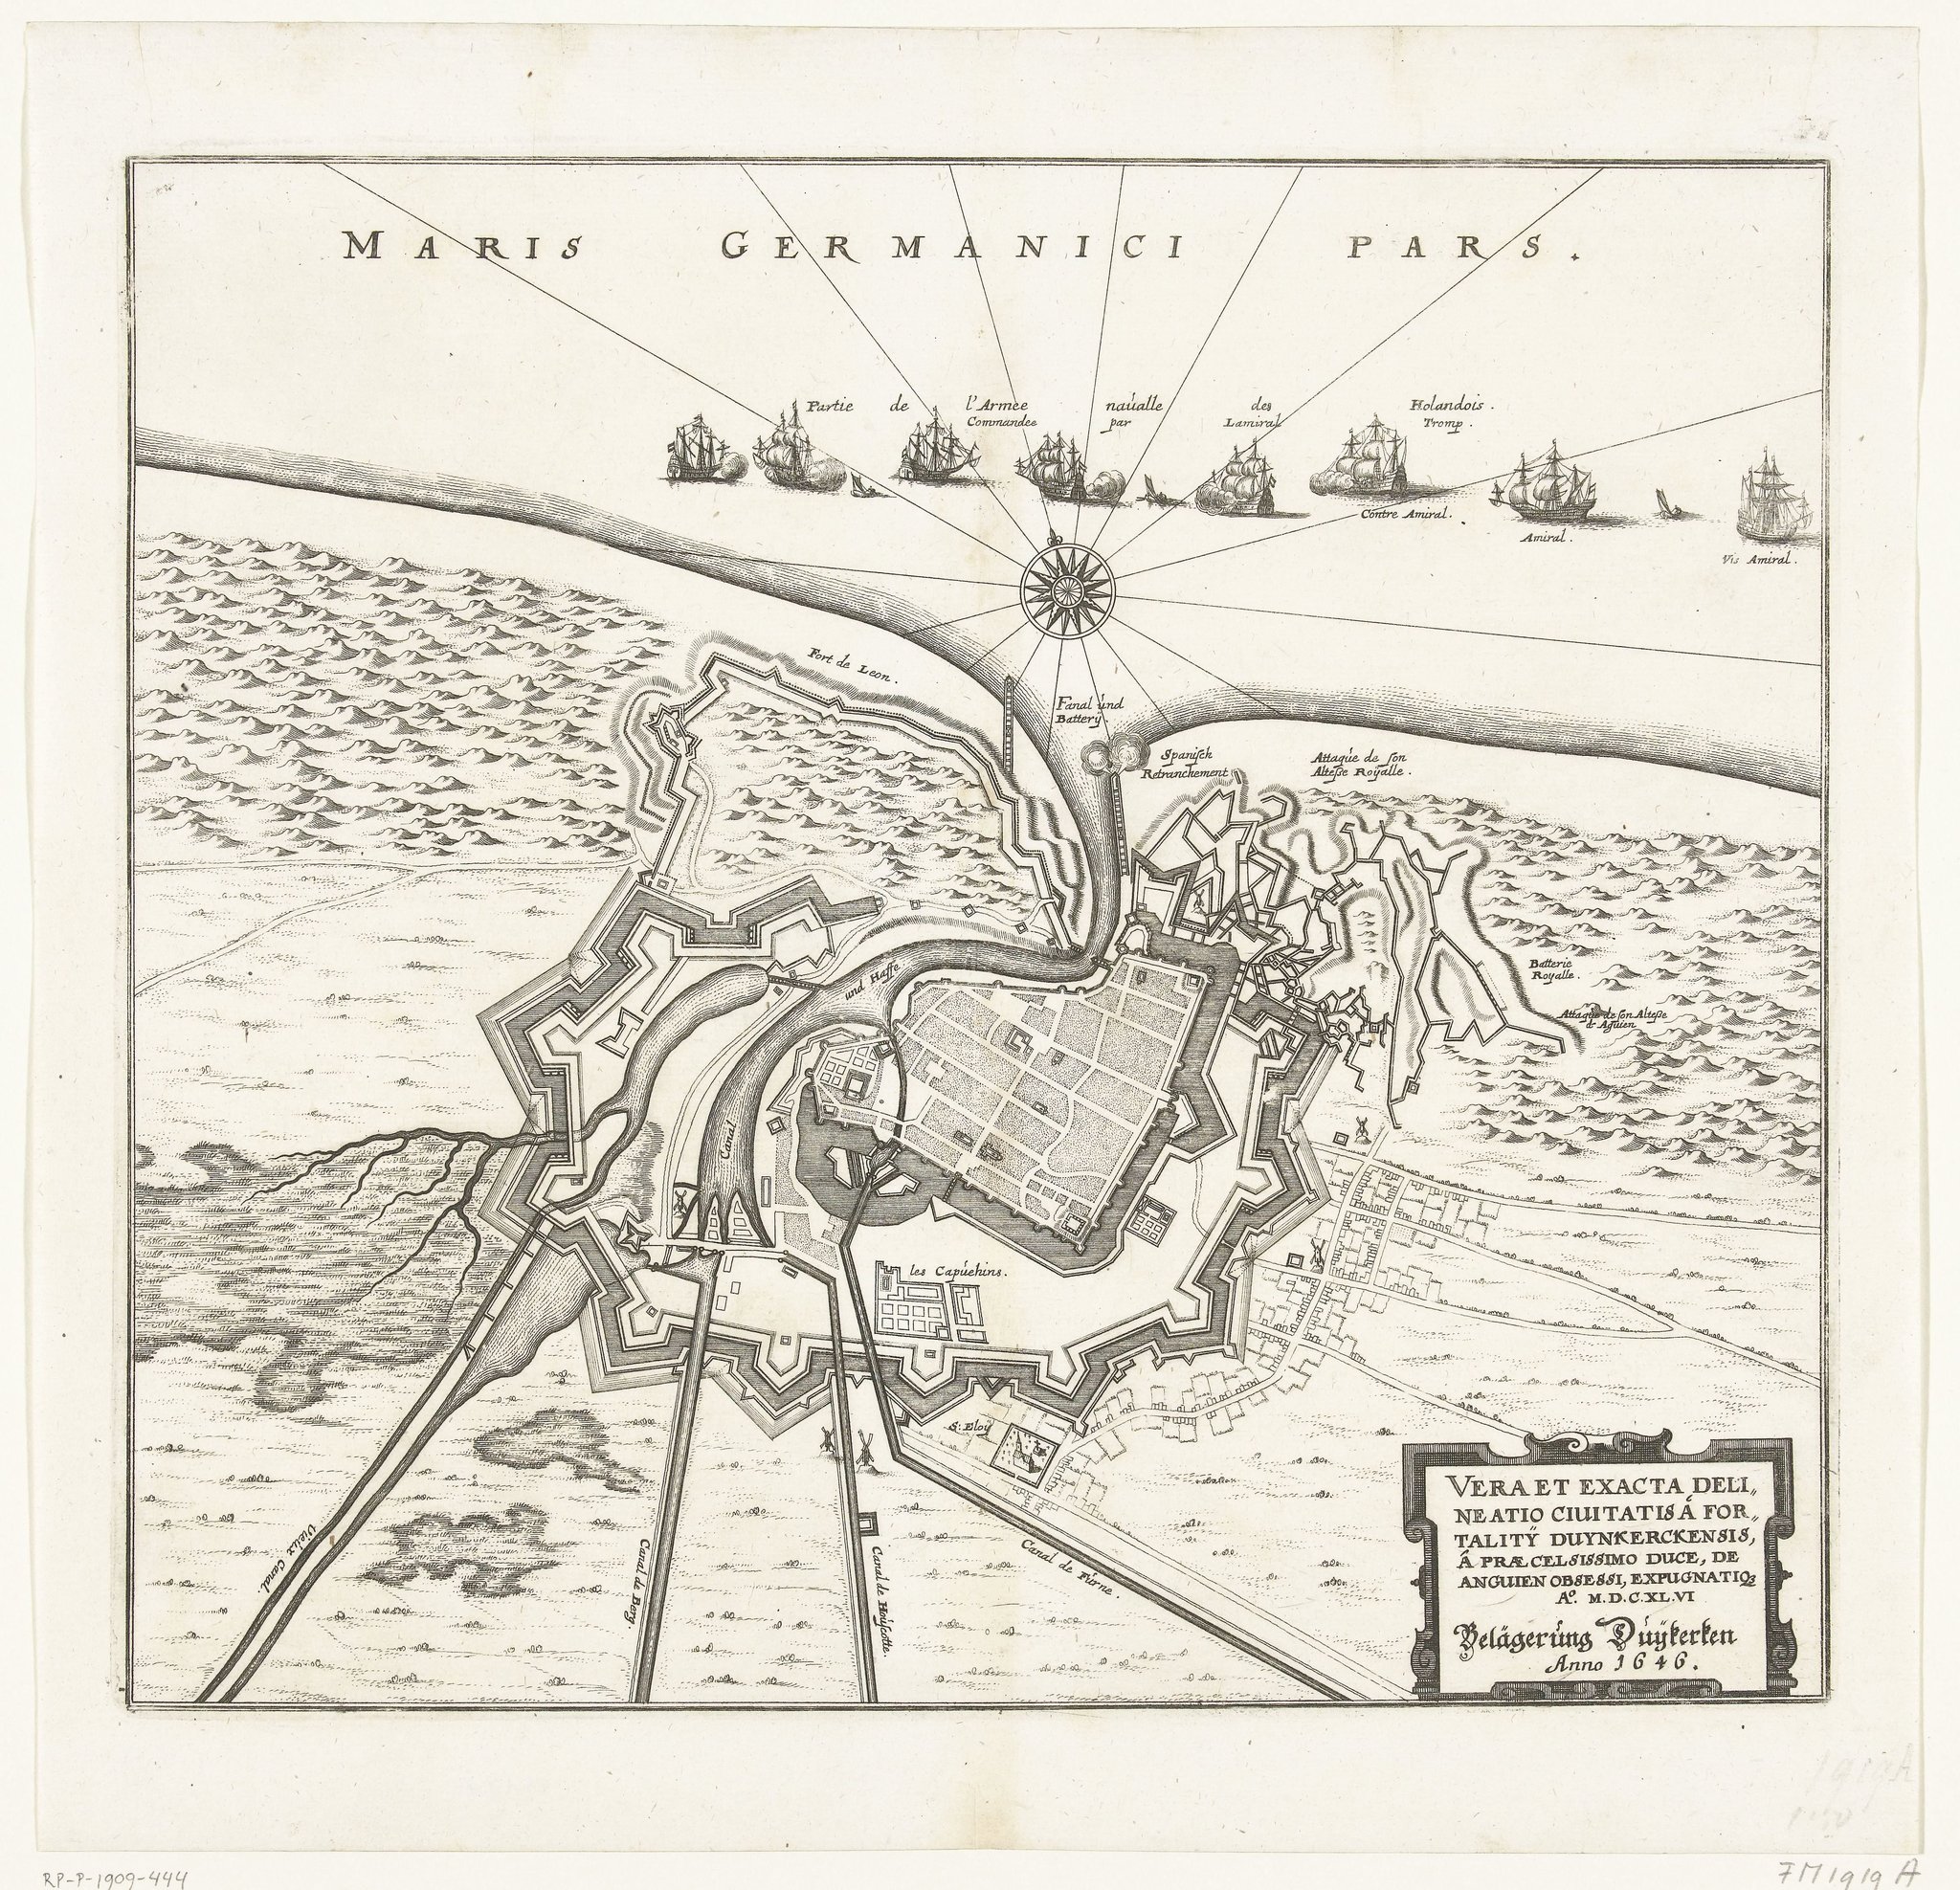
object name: map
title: Vera et exacta delineatio civitatis a fortality Duynkerckensis, a prae celsissimo duce, de Anguien obsessi, expugnatiq. Ao. MDCXLVI / Belägerung Duykerken Anno 1646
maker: Anonymous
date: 1649-1655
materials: paper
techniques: etching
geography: germany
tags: lodewijk ii de bourbon-condé (hertog van enghien), brielle, maarten harpertszoon tromp, siege, position war, maps of cities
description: Plattegrond van Duinkerken, belegerd door het Franse leger onder de hertog van Enghien, 1646. Centraal een plattegrond van de belegerde stad met alle versterkingen. Voor de kust de Staatse vloot onder Maarten Tromp.